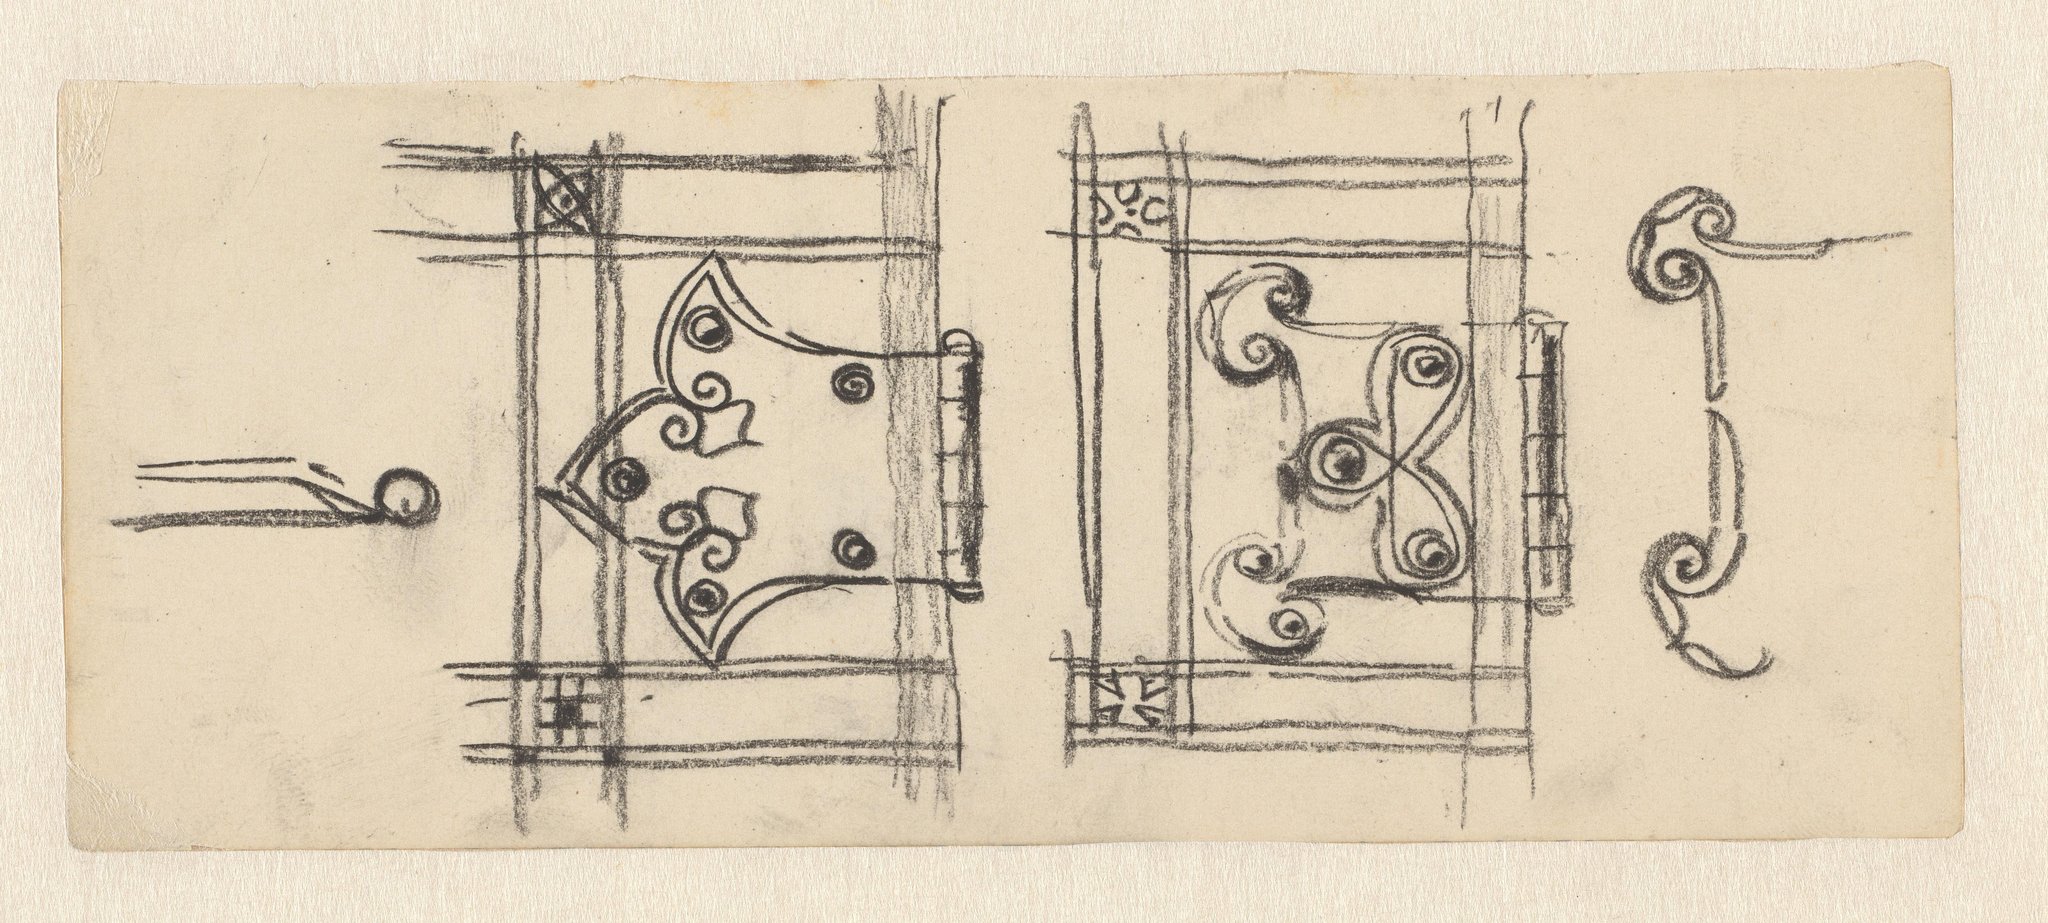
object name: design drawing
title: Twee ontwerpen voor de decoratie van een boekband met een klamp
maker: gerrit willem dijsselhof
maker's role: designer, draughtsman, print maker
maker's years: 1866-1924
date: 1881-1924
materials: chalk, paper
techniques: drawing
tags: book-cover, binding